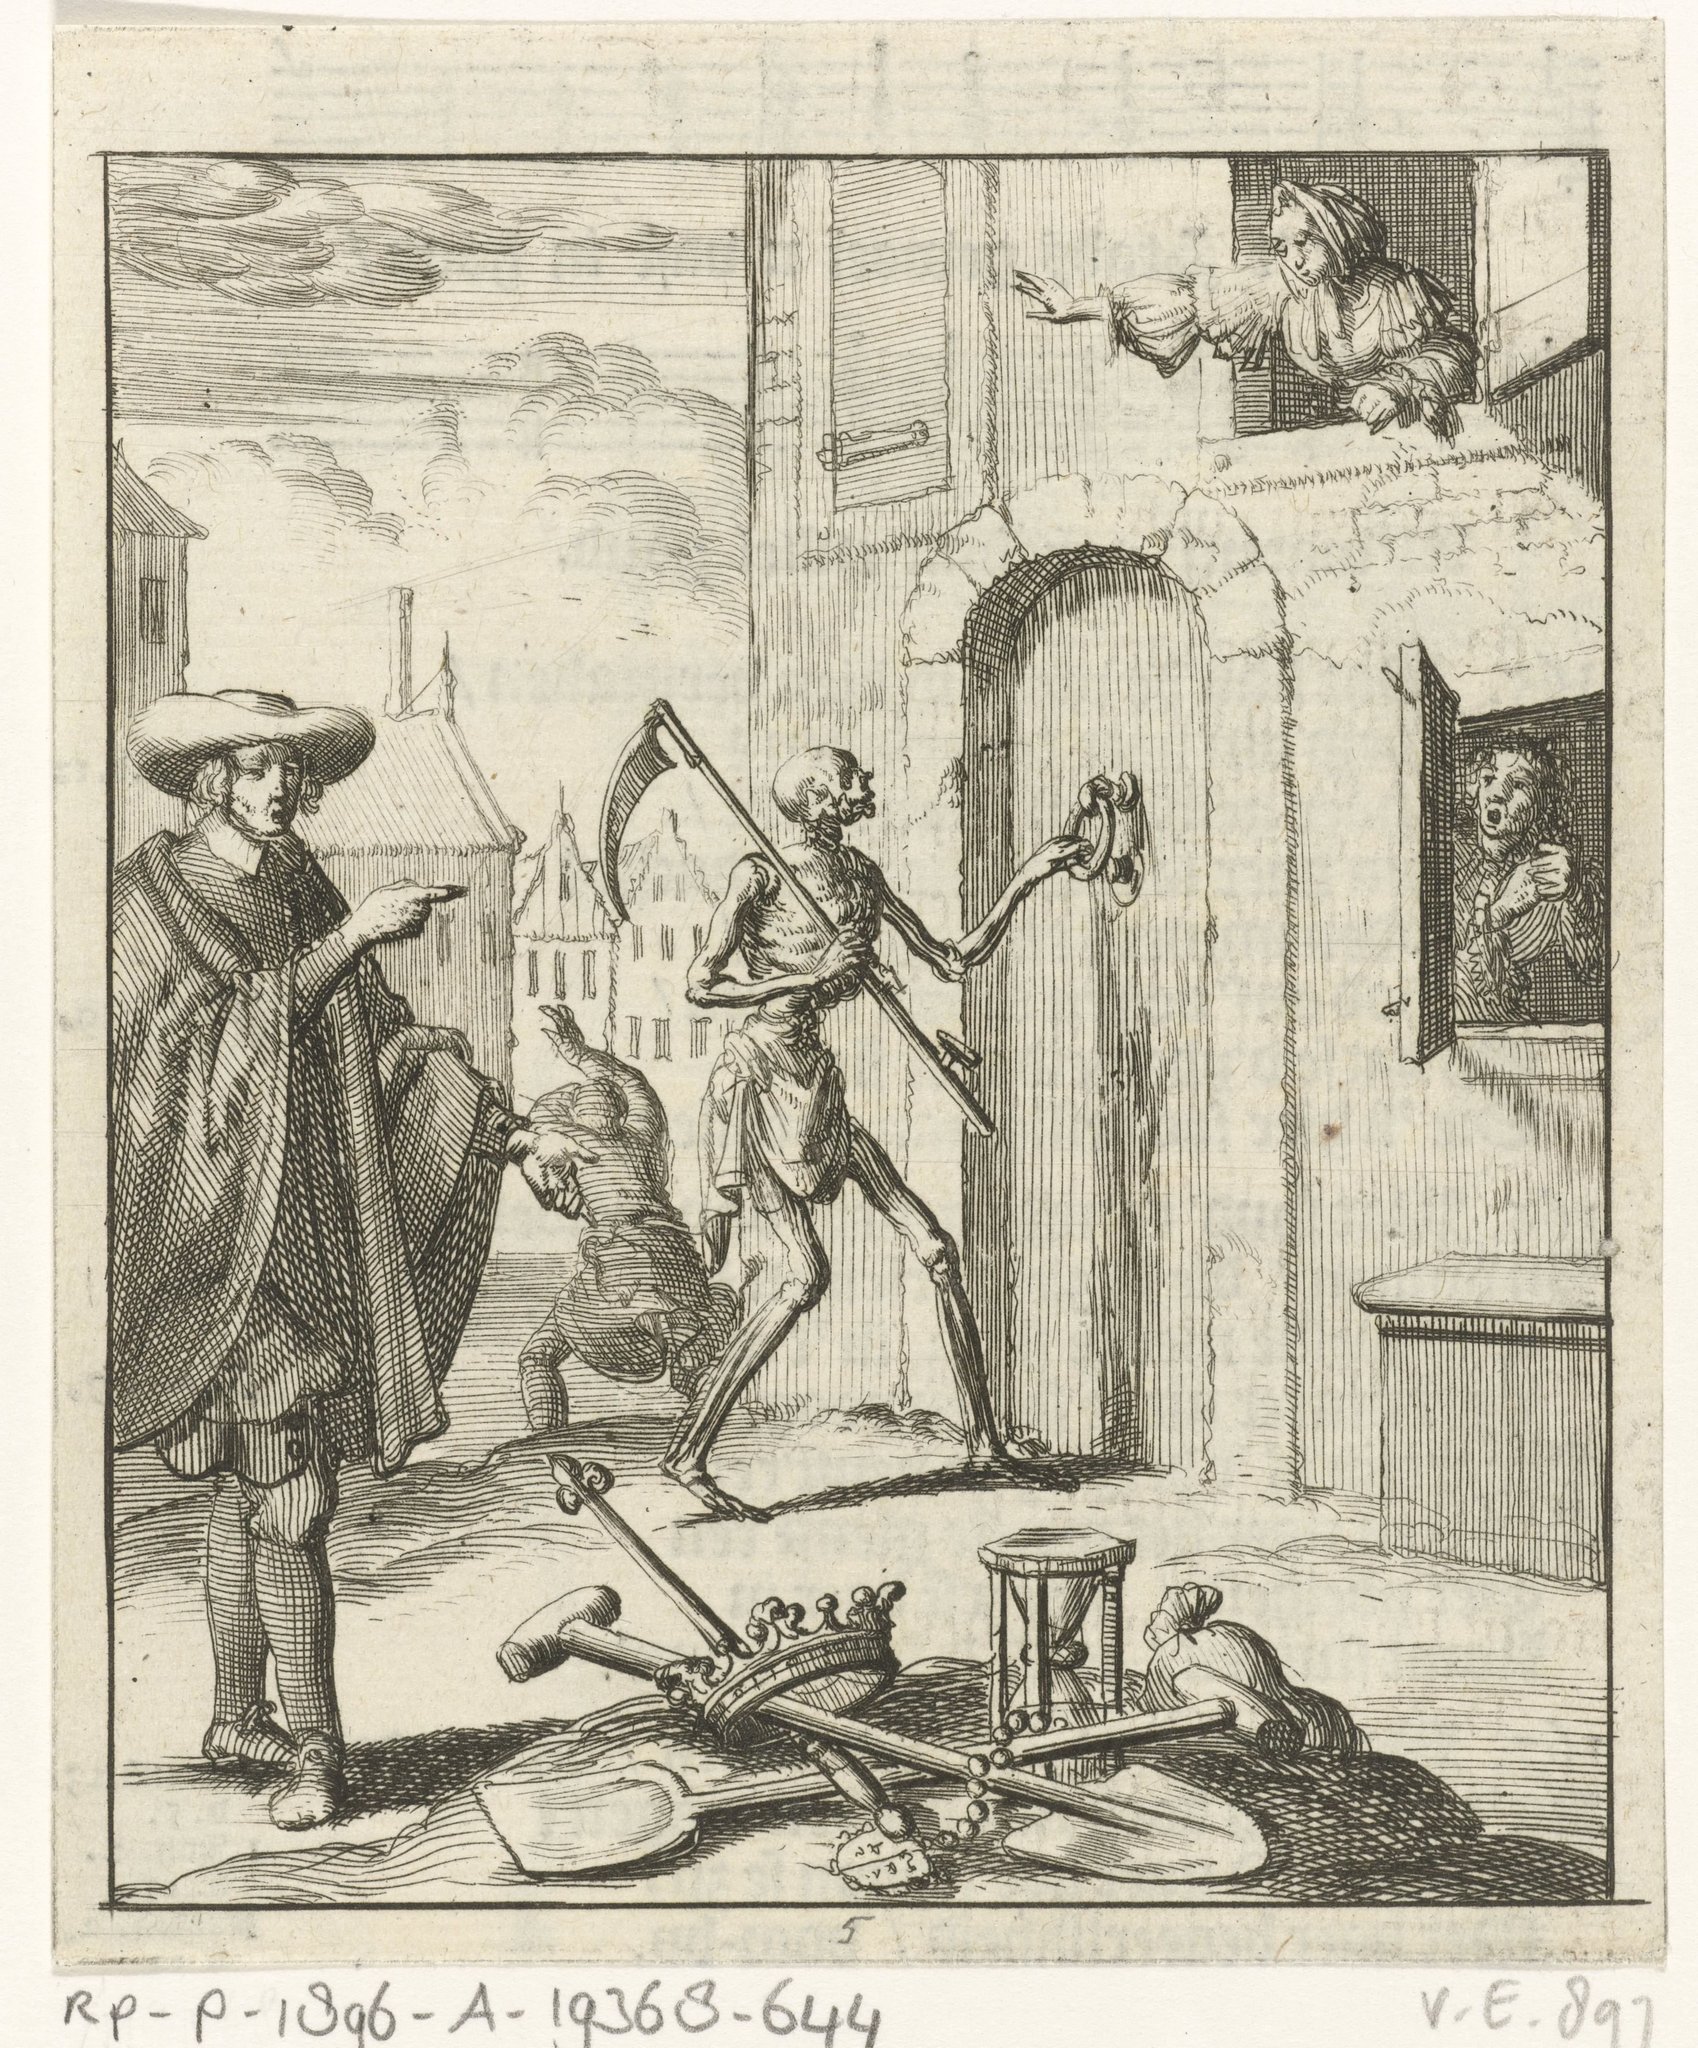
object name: book illustration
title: Schrijver Willem Sluiter wijst naar diverse voorwerpen en naar een huis waar een vrouw geschrokken is van de Dood die aanklopt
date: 1687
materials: paper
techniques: etching, letterpress printing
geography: amsterdam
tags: knocking at the door, death as skeleton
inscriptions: collector's mark: Lugt 2228, number: ‘5’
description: Illustratie uit: Sluiter, Willem. Buiten- eensaem huis- somer- en winter-leven. Amsterdam: Gerbrandt Schagen, 1687, p. 48.